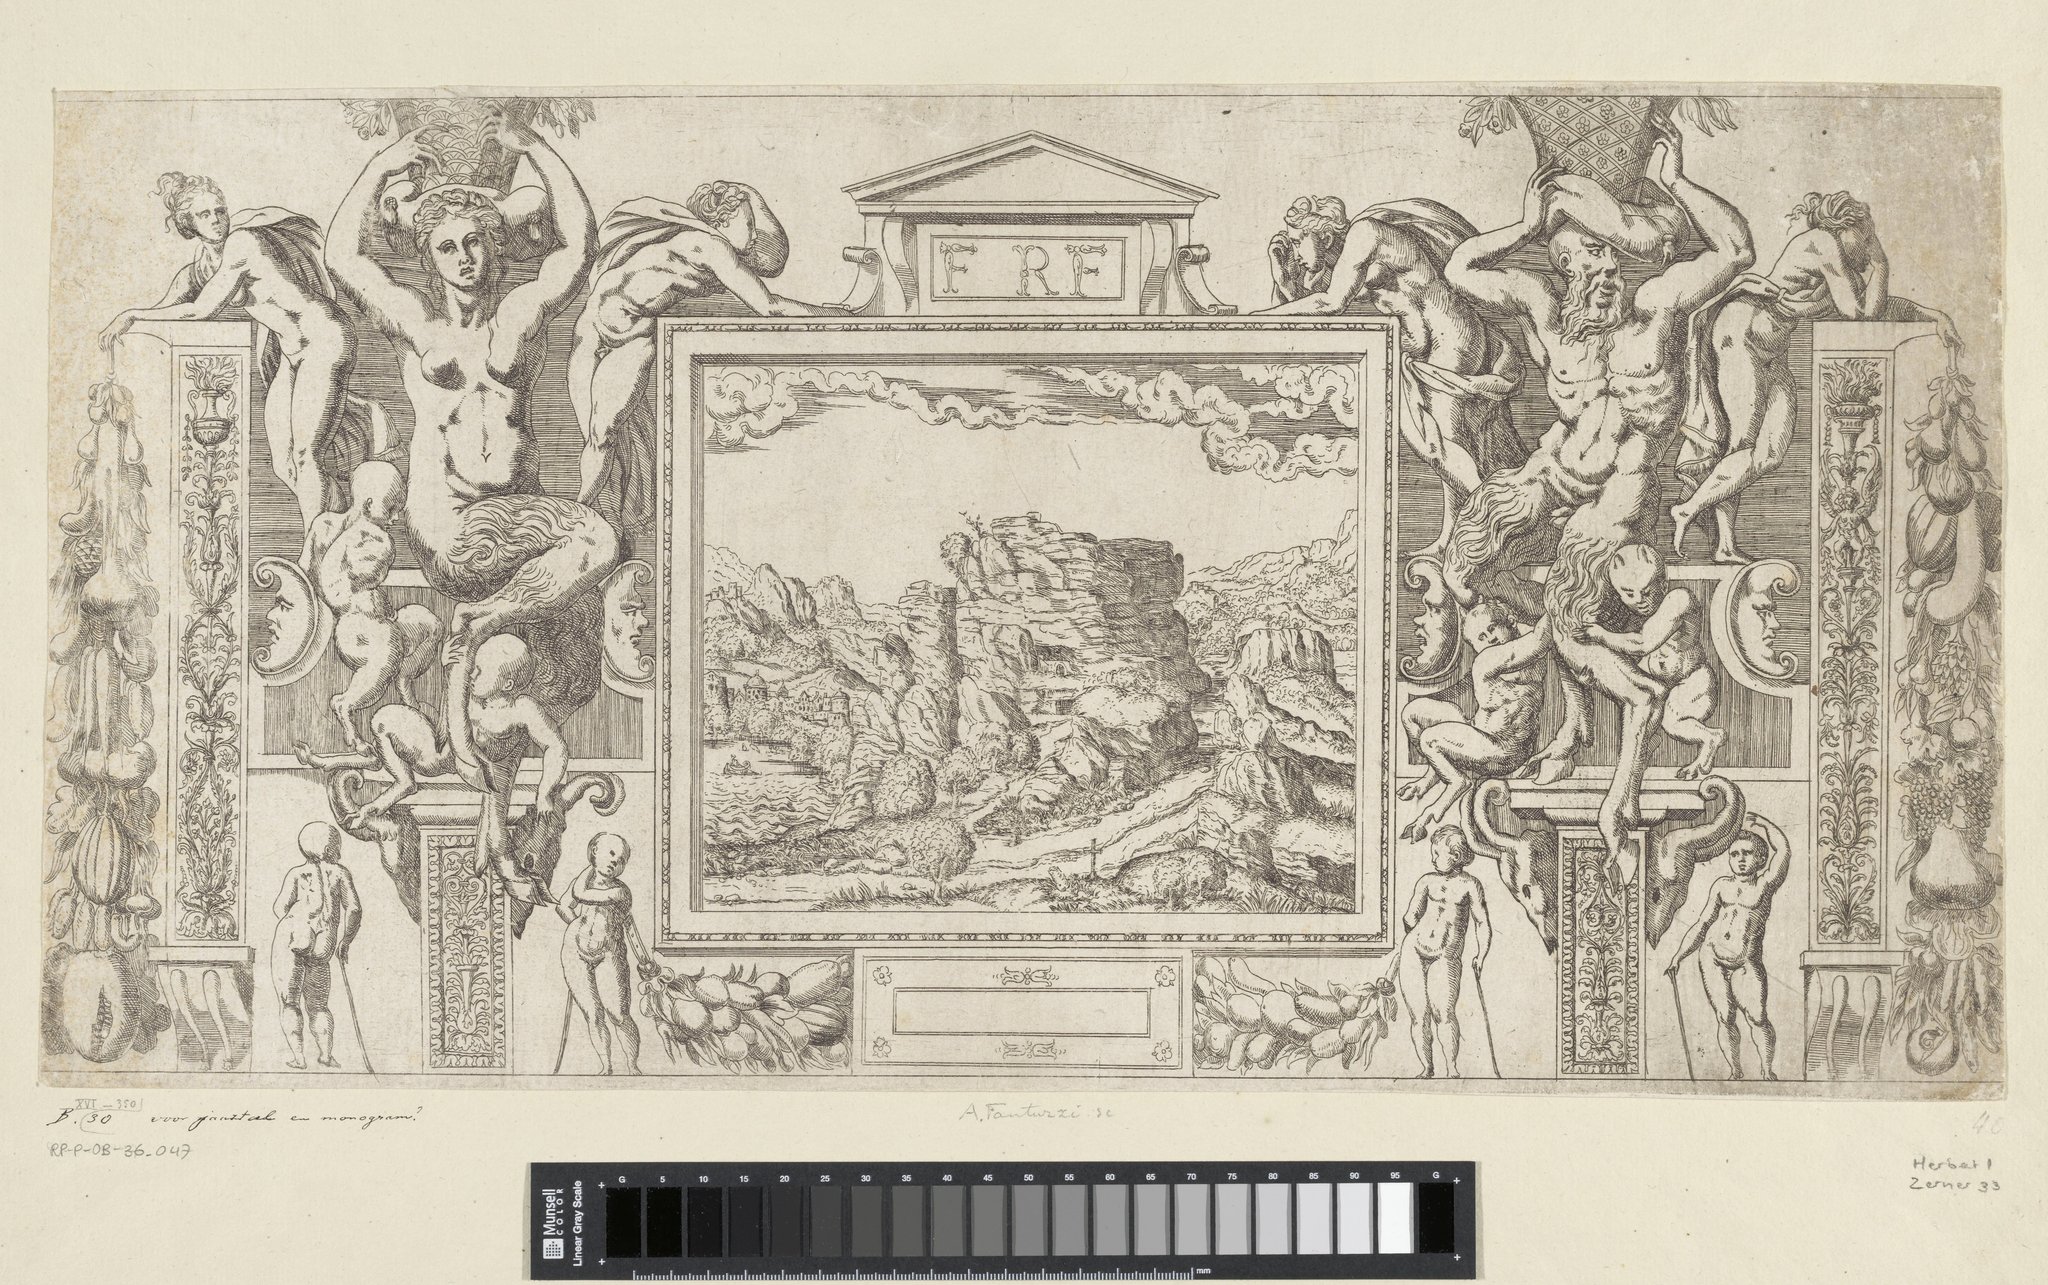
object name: print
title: Berglandschap met omlijsting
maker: antonio fantuzzi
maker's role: painter, print maker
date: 1543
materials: paper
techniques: etching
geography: fontainebleau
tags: satyr(s) (in general), ornament ~ festoon, garland, cupids: 'amores', 'amoretti', 'putti', mountains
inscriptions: collector's mark: Lugt 240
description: Naar de omlijsting van de allegorie ijdelheid overwonnen, stucco in gallerie van François I te Fontainebleau. In de prent is de allegorie vervangen door een landschap.